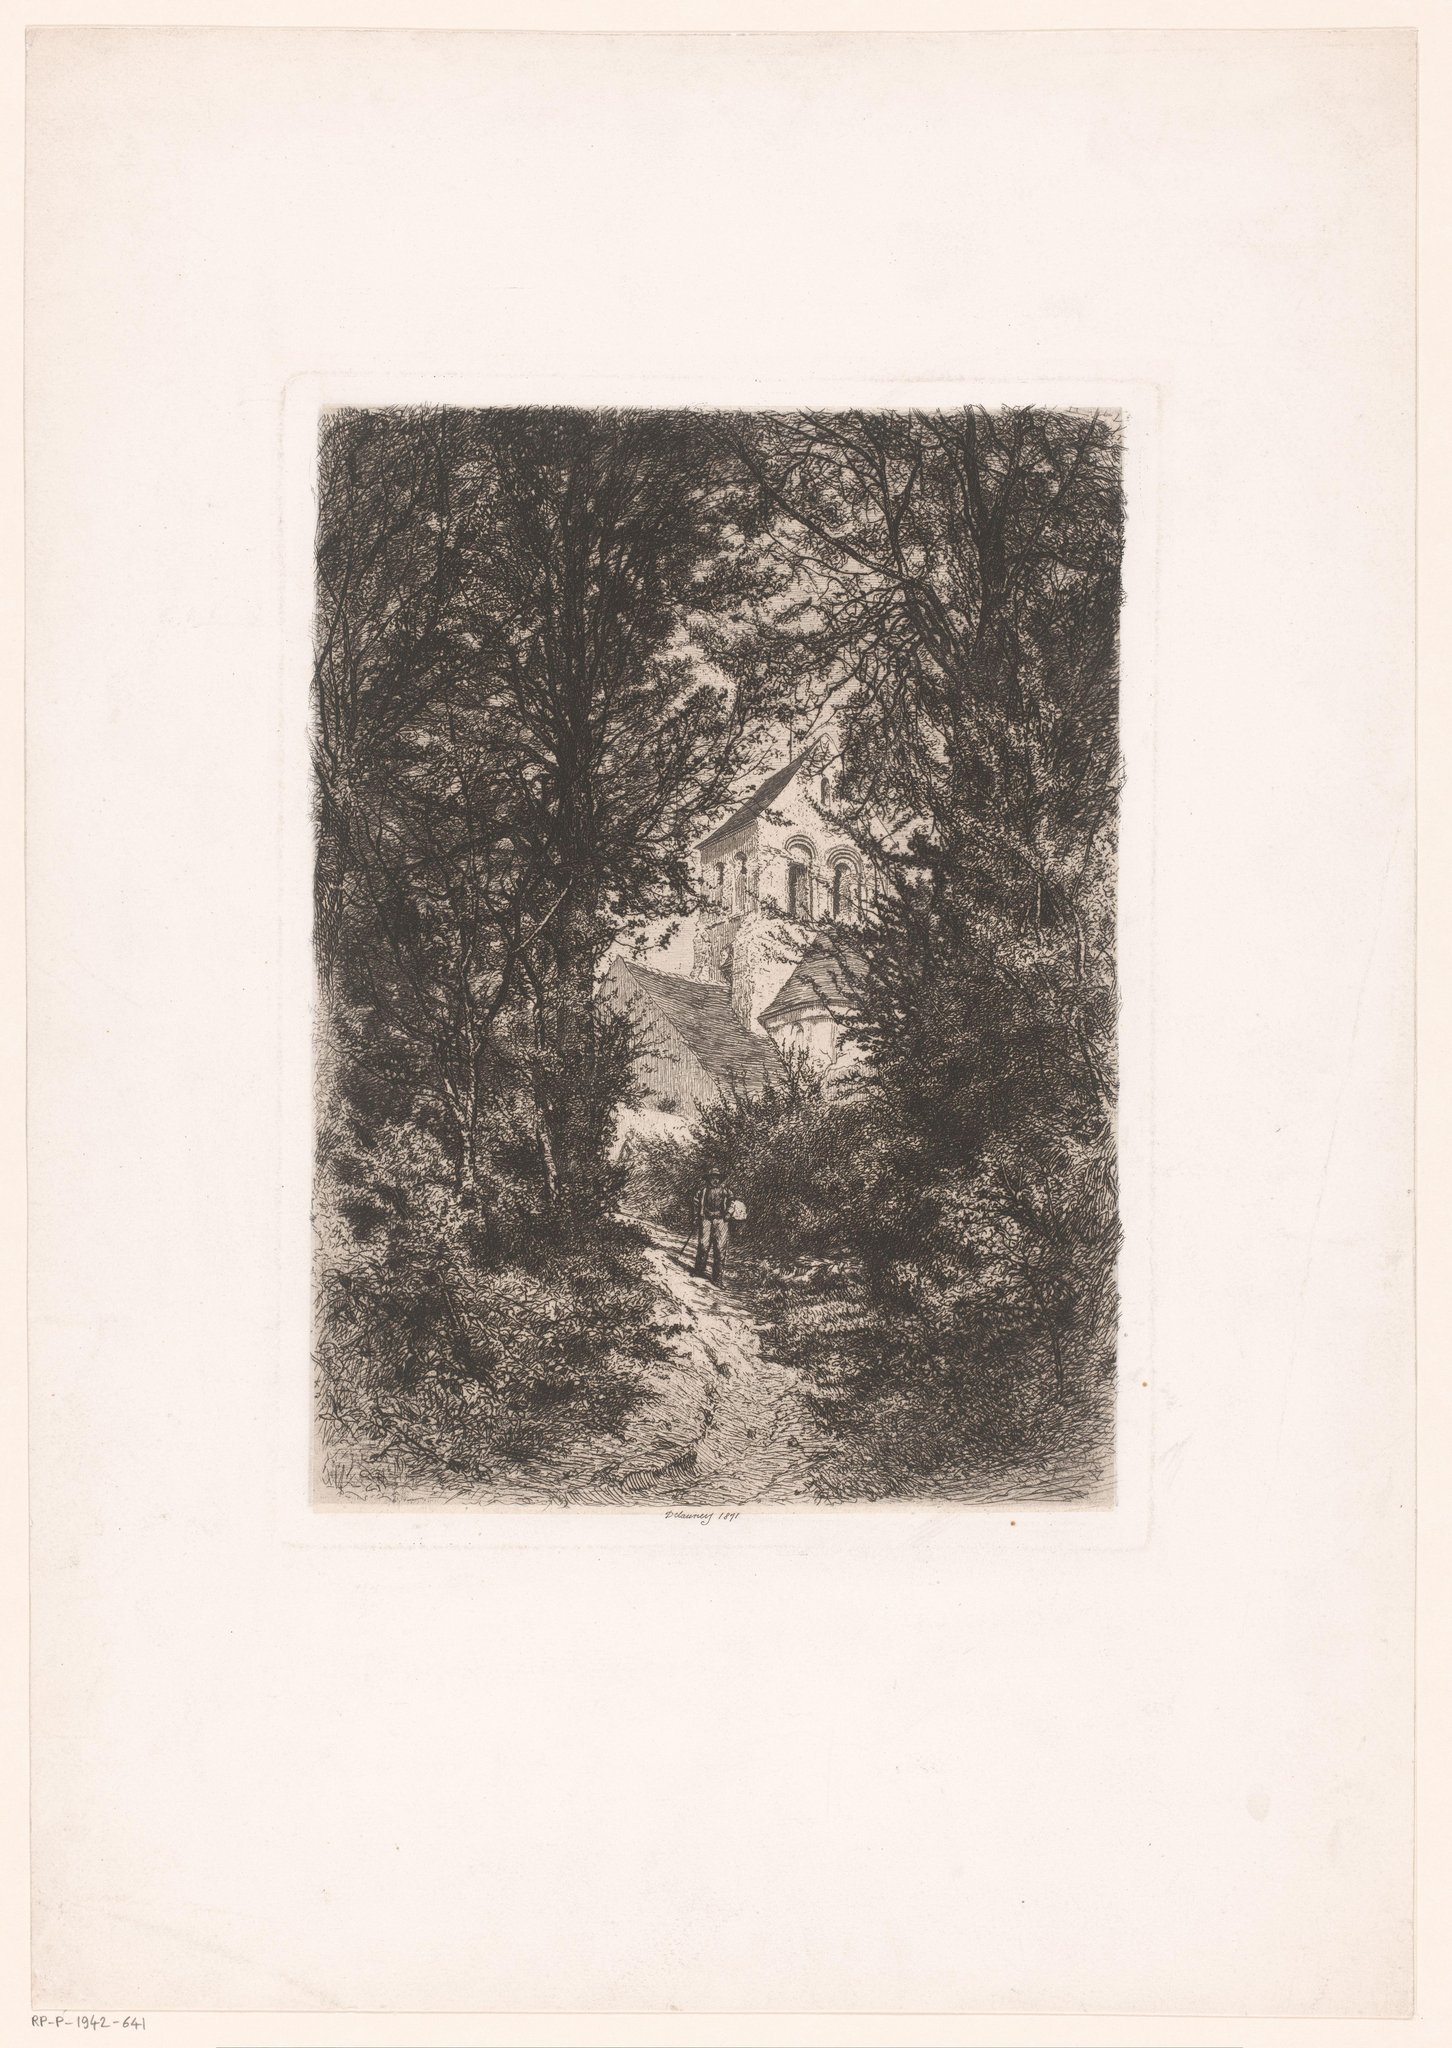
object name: print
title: Bosgezicht met een kerk op de achtergrond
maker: alfred alexandre delauney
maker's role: print maker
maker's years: 1830-1895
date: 1871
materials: paper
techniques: drypoint, etching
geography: france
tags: forest, wood, forest path or lane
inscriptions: collector's mark: Lugt 2228